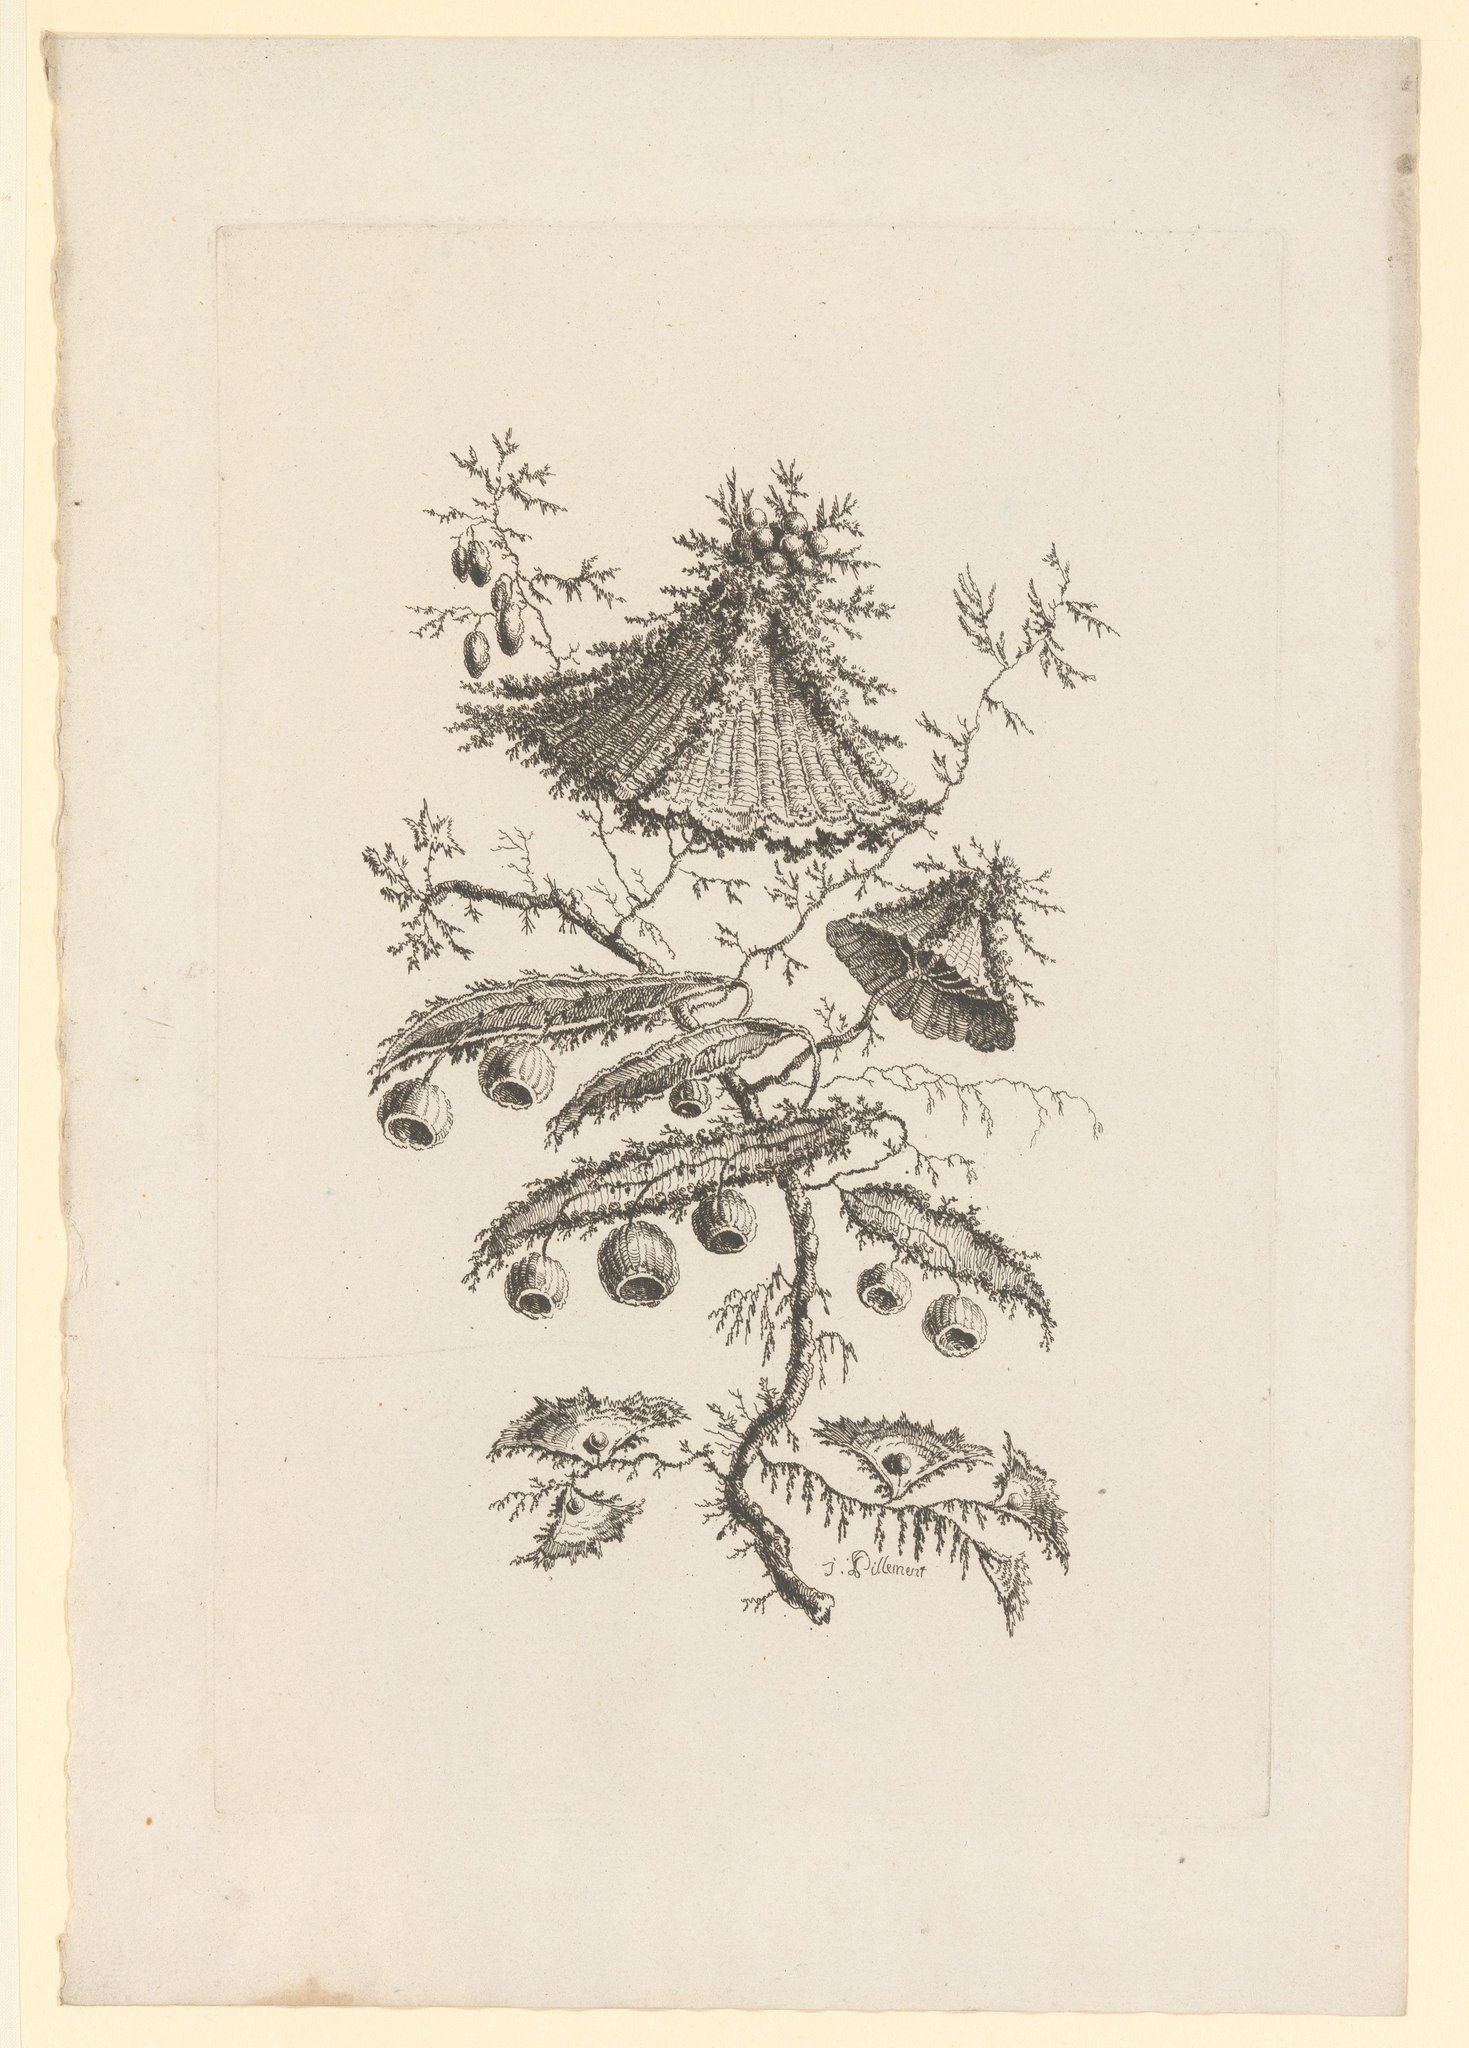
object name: print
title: Fleures Persannes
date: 1767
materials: paper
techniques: etching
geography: paris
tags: flowers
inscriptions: collector's mark: Lugt 2760, collector's mark: Lugt 2228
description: Prent is onderdeel van een serie van zes.